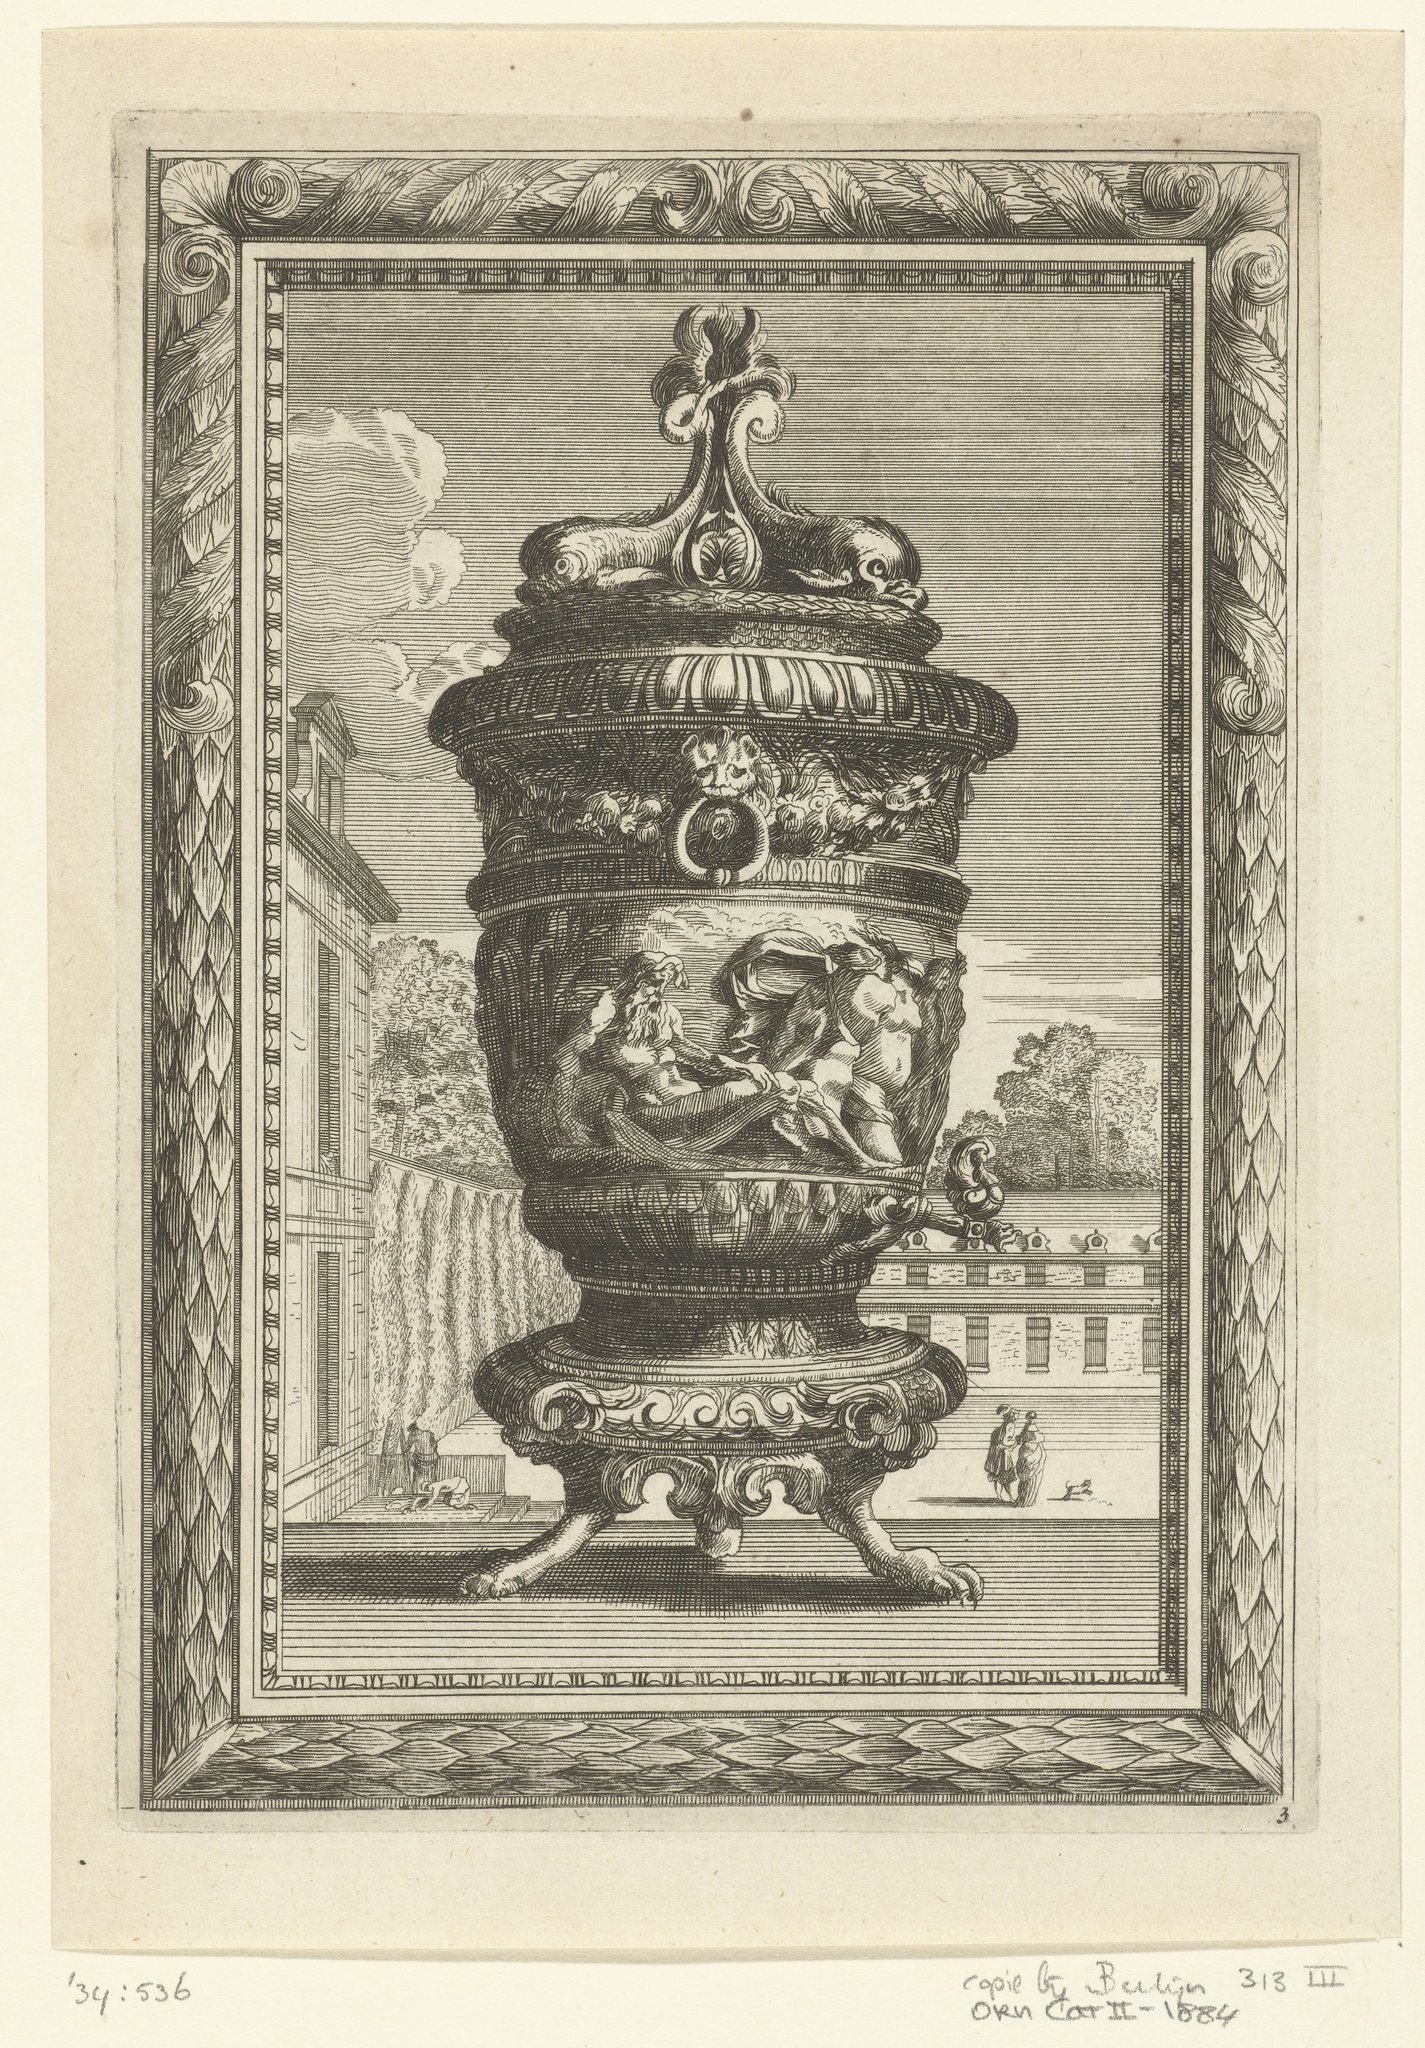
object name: print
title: Waterfontein met twee dolfijnen bovenop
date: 1655-1678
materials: paper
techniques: etching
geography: france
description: De fontein is afgebeeld met de kraan aan de rechterkant.